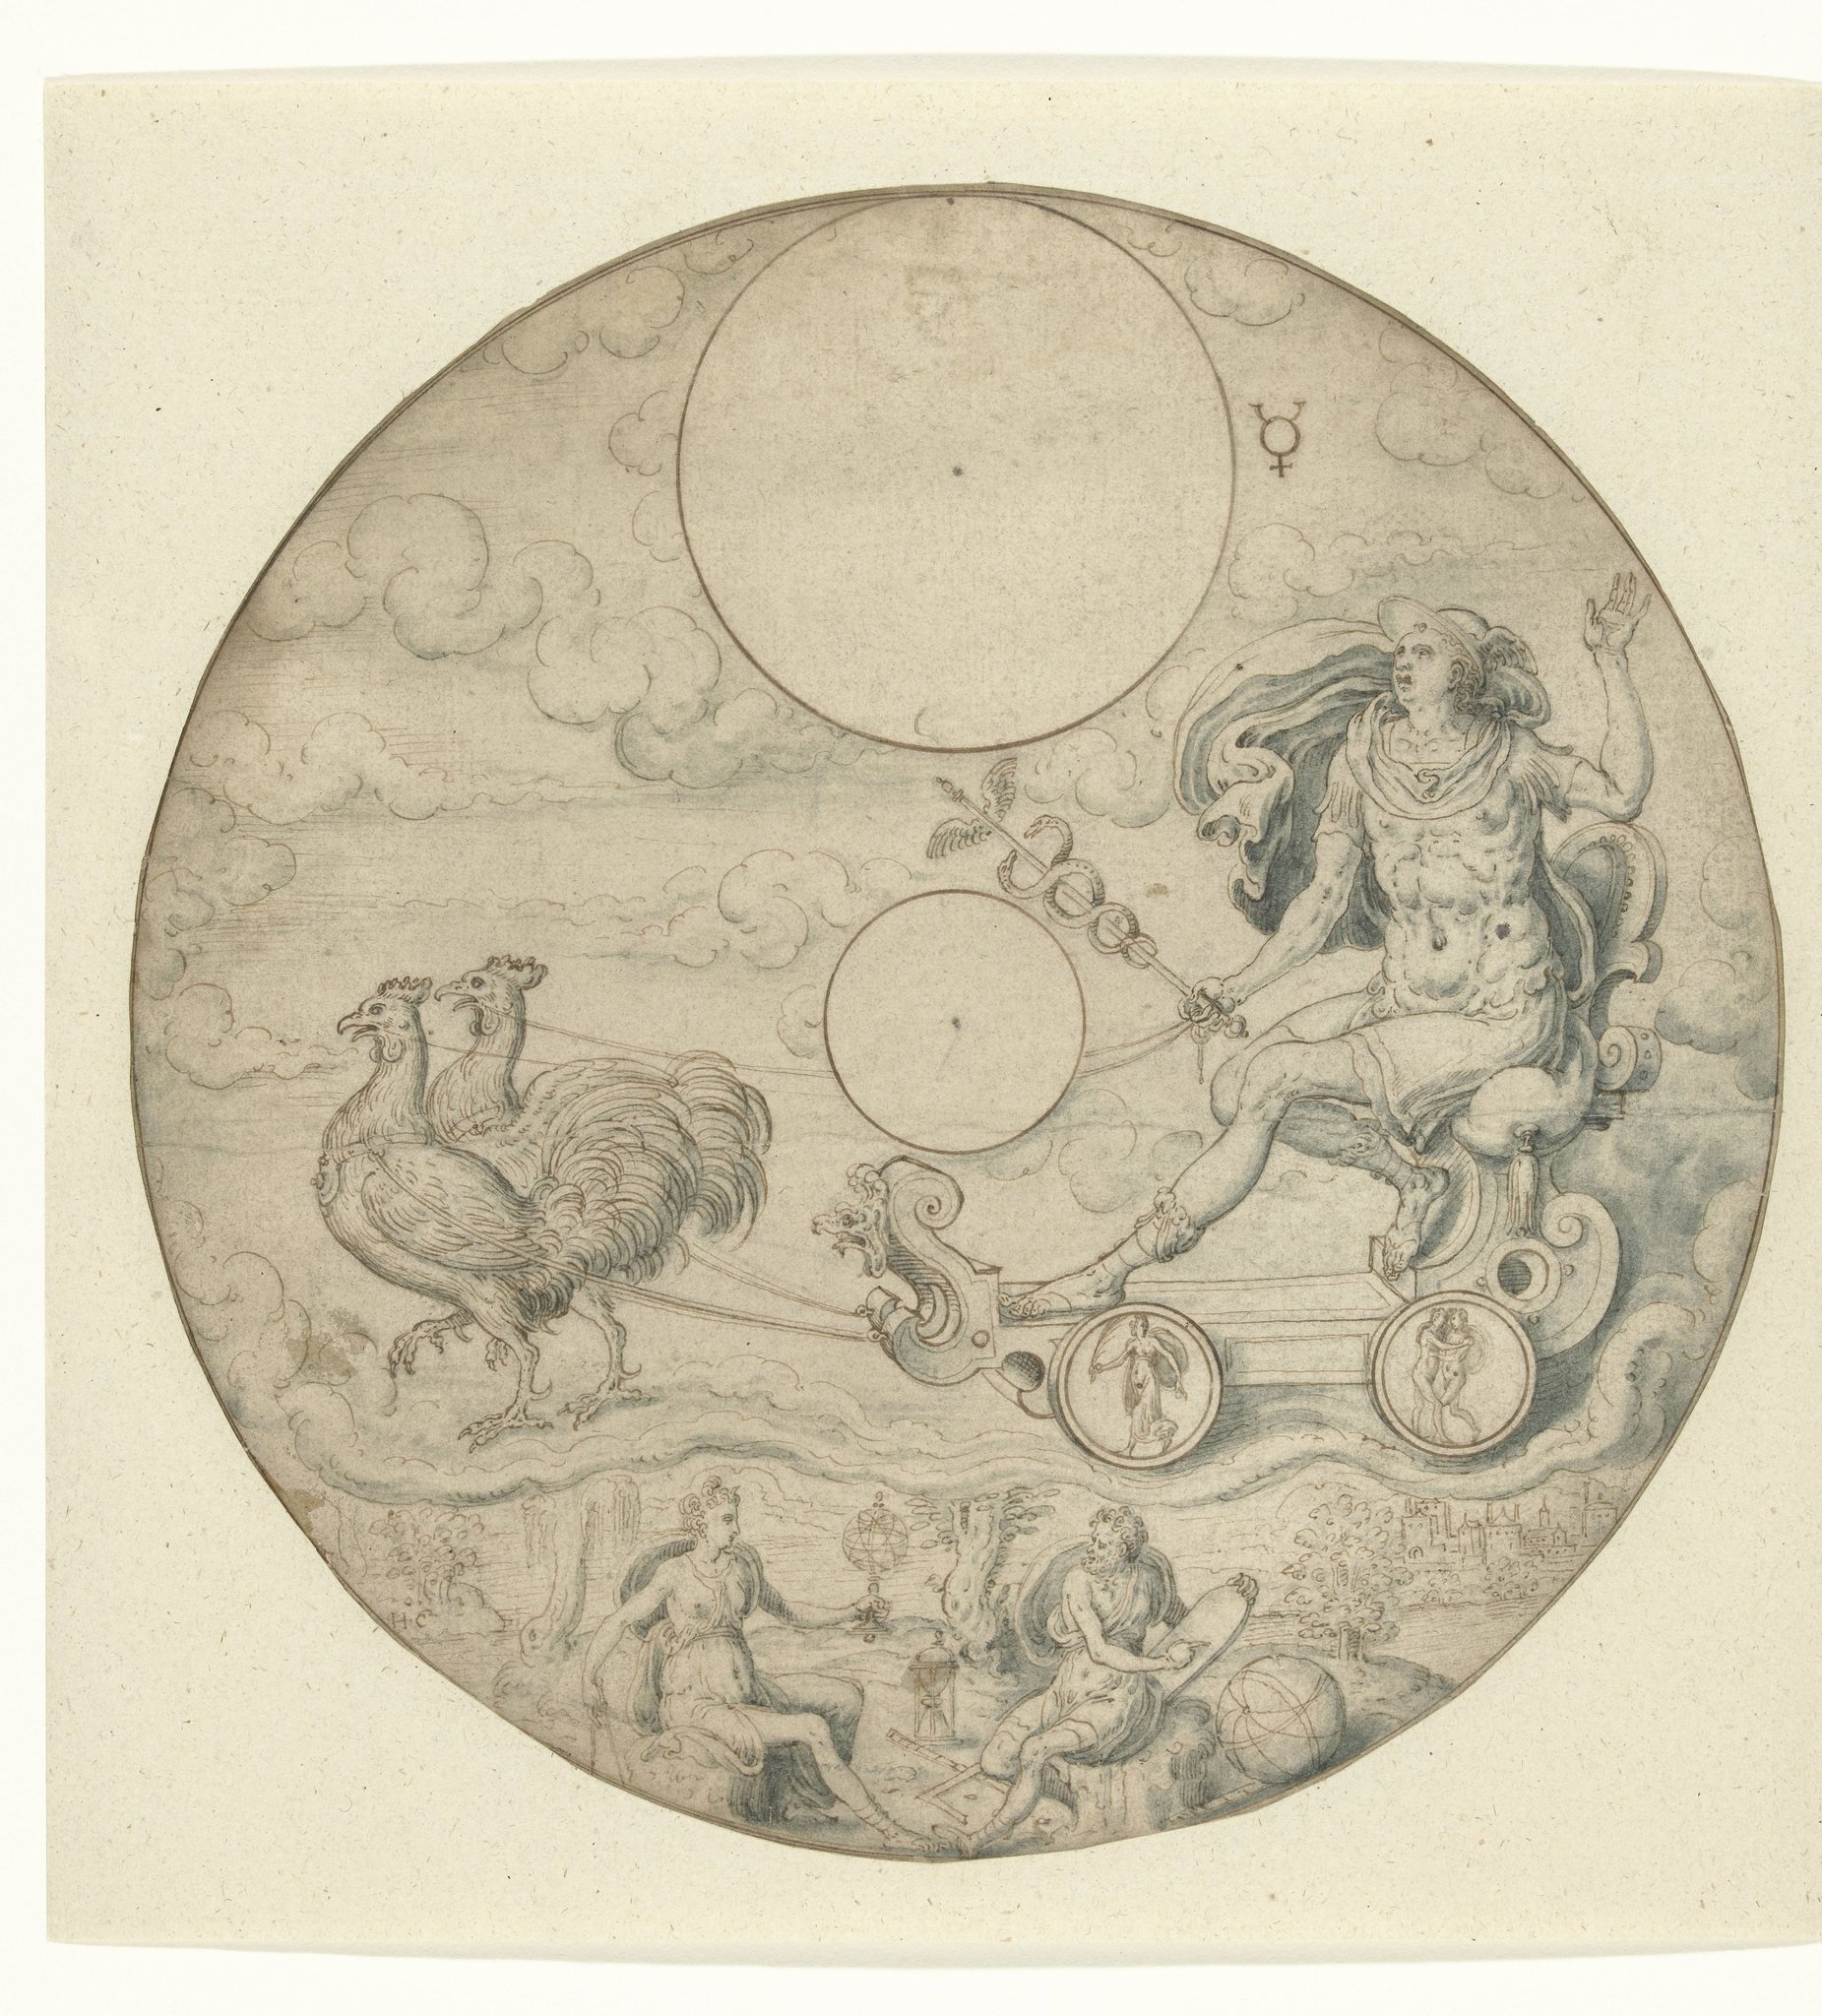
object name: design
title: Planeet Mercurius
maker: hans collaert (i)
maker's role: draughtsman, print maker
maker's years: 1520-1581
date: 1558-1568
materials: ink, paper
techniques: brush, pen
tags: mercury and his children ('planetenkinder'), mercury and his children ('planetenkinder') ~ gemini and virgo, triumph of mercury; 'carro di mercurio' (ripa)